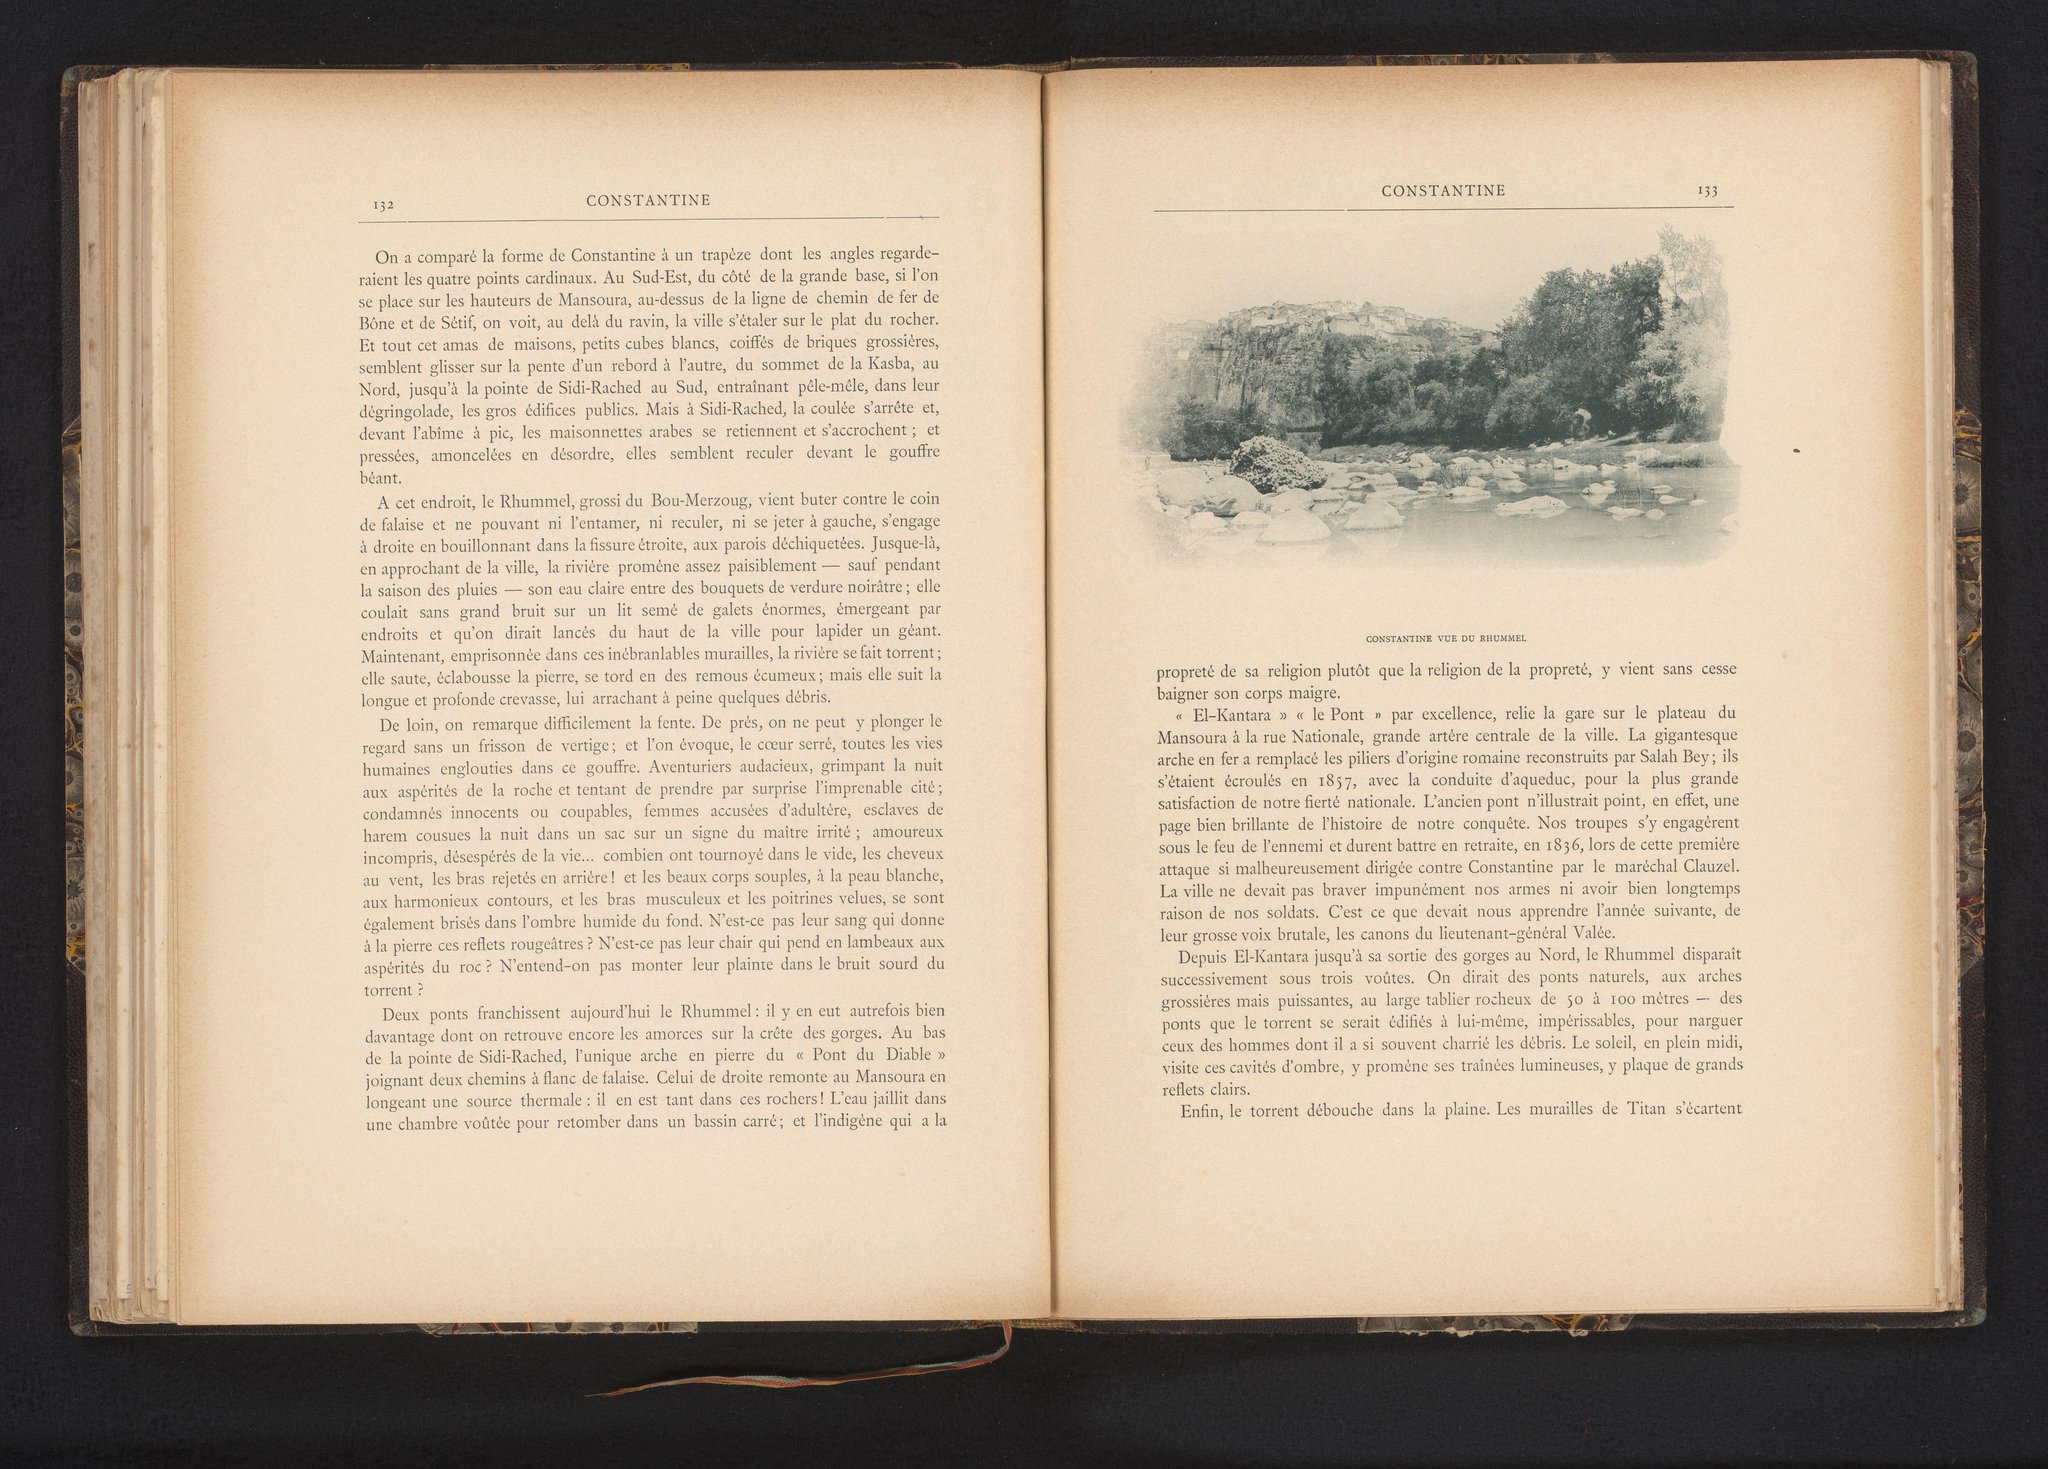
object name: photomechanical print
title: Gezicht op de rivier de Rummel bij Constantine, Algerije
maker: jules gervais-courtellemont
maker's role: fotograaf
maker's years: 1863-1931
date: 1888-1893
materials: paper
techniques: photograph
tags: river